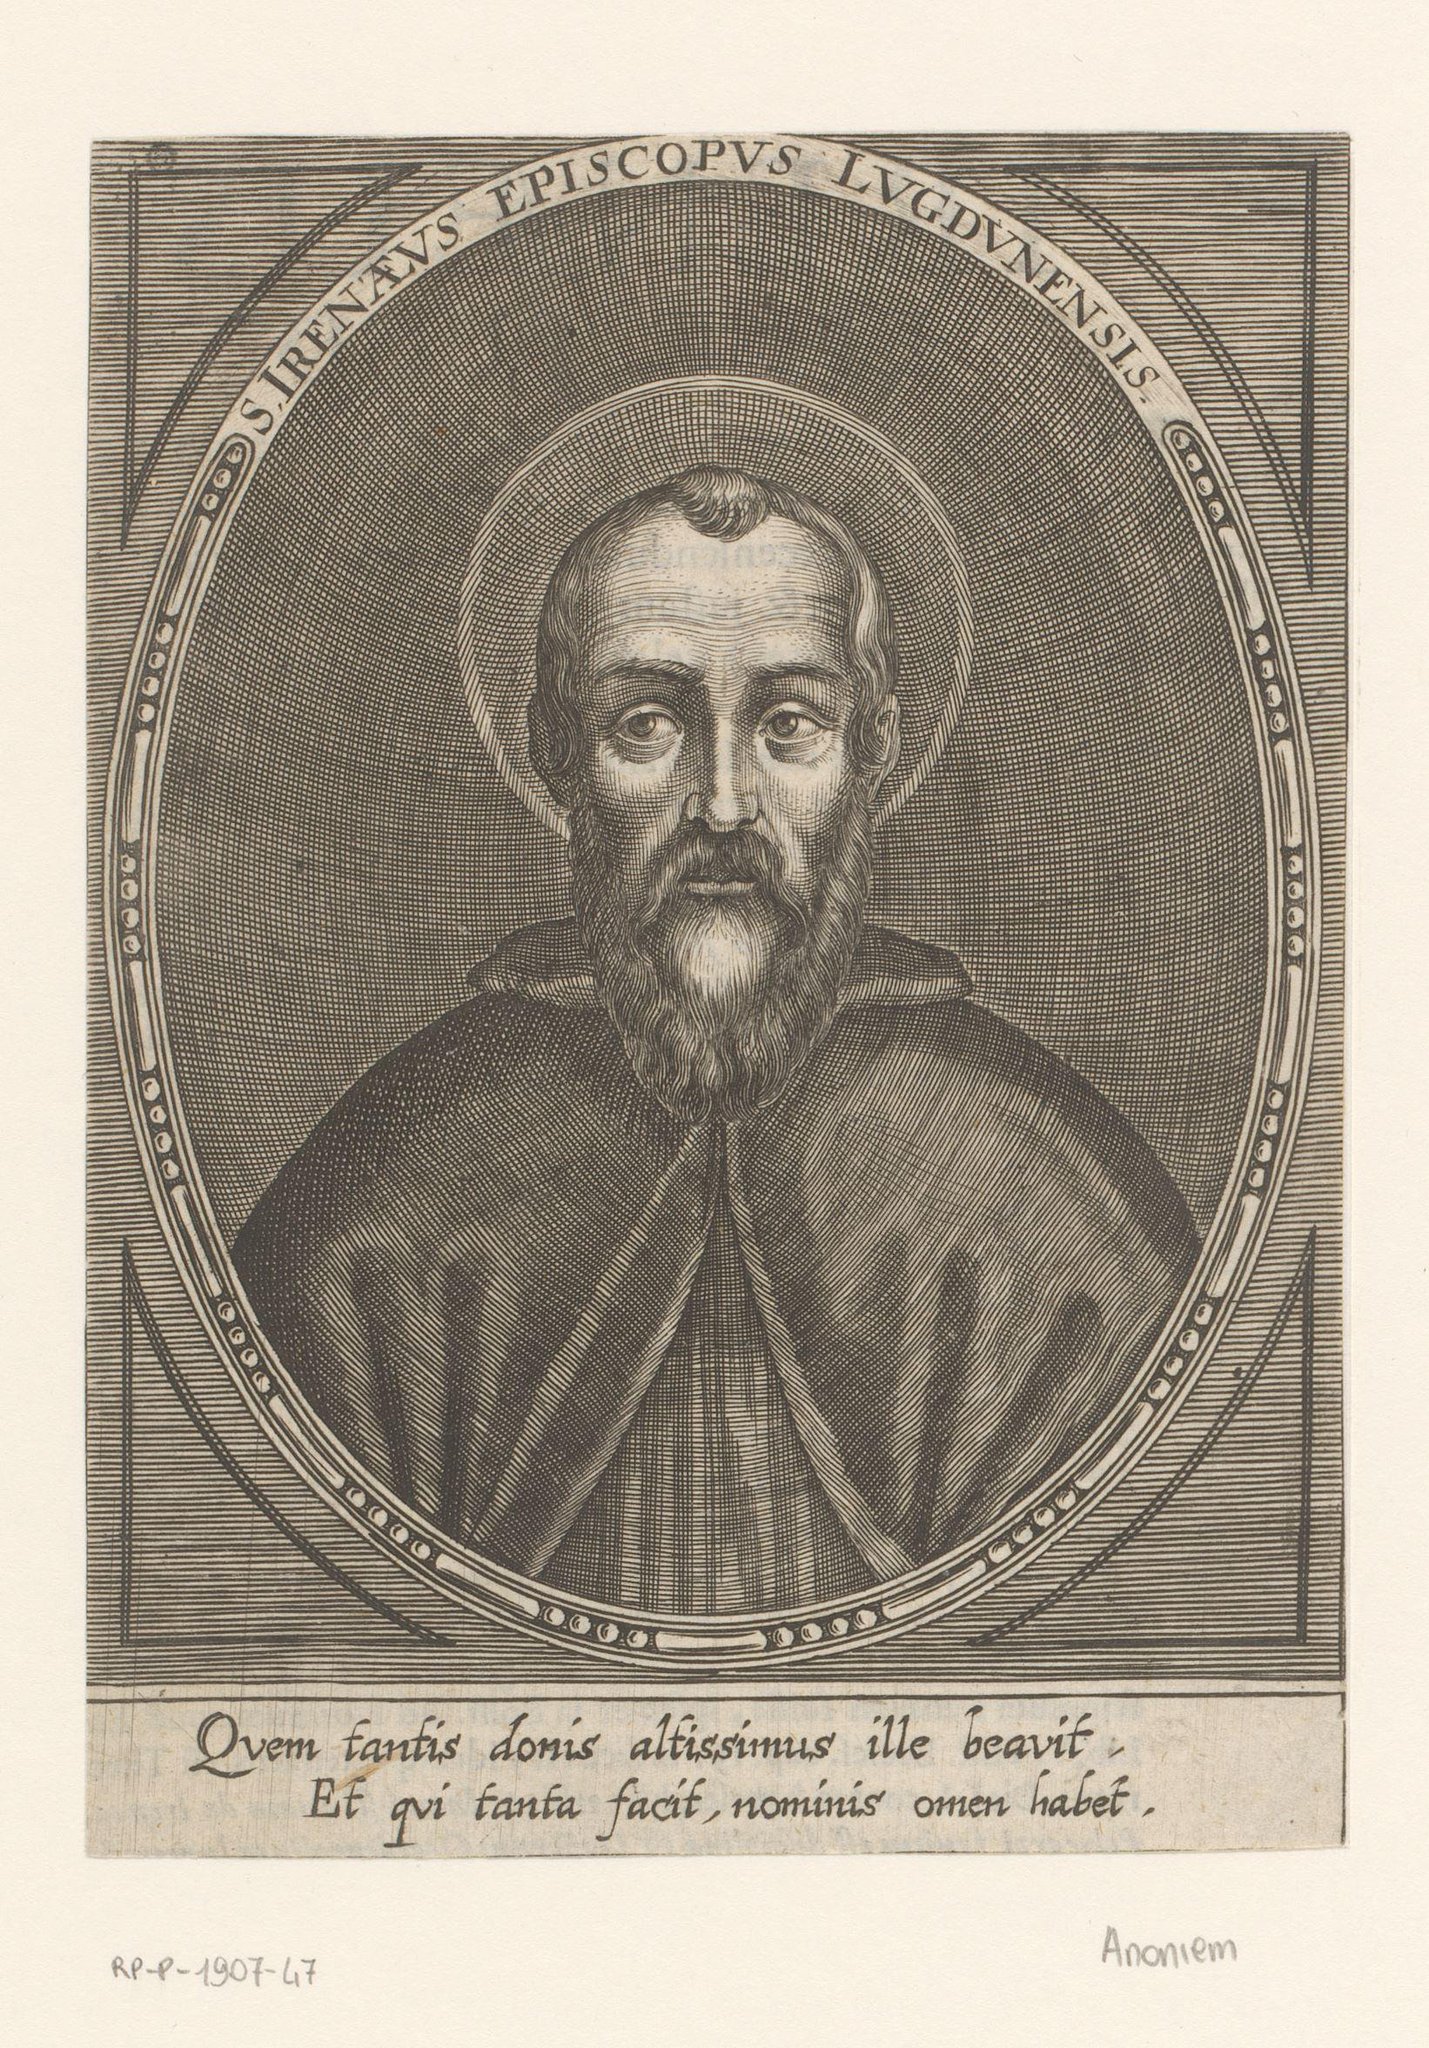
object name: print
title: H. Ireneüs van Lyon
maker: Anonymous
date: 1600-1699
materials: paper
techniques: engraving, letterpress printing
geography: netherlands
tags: historical persons, saints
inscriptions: collector's mark: Lugt 2228